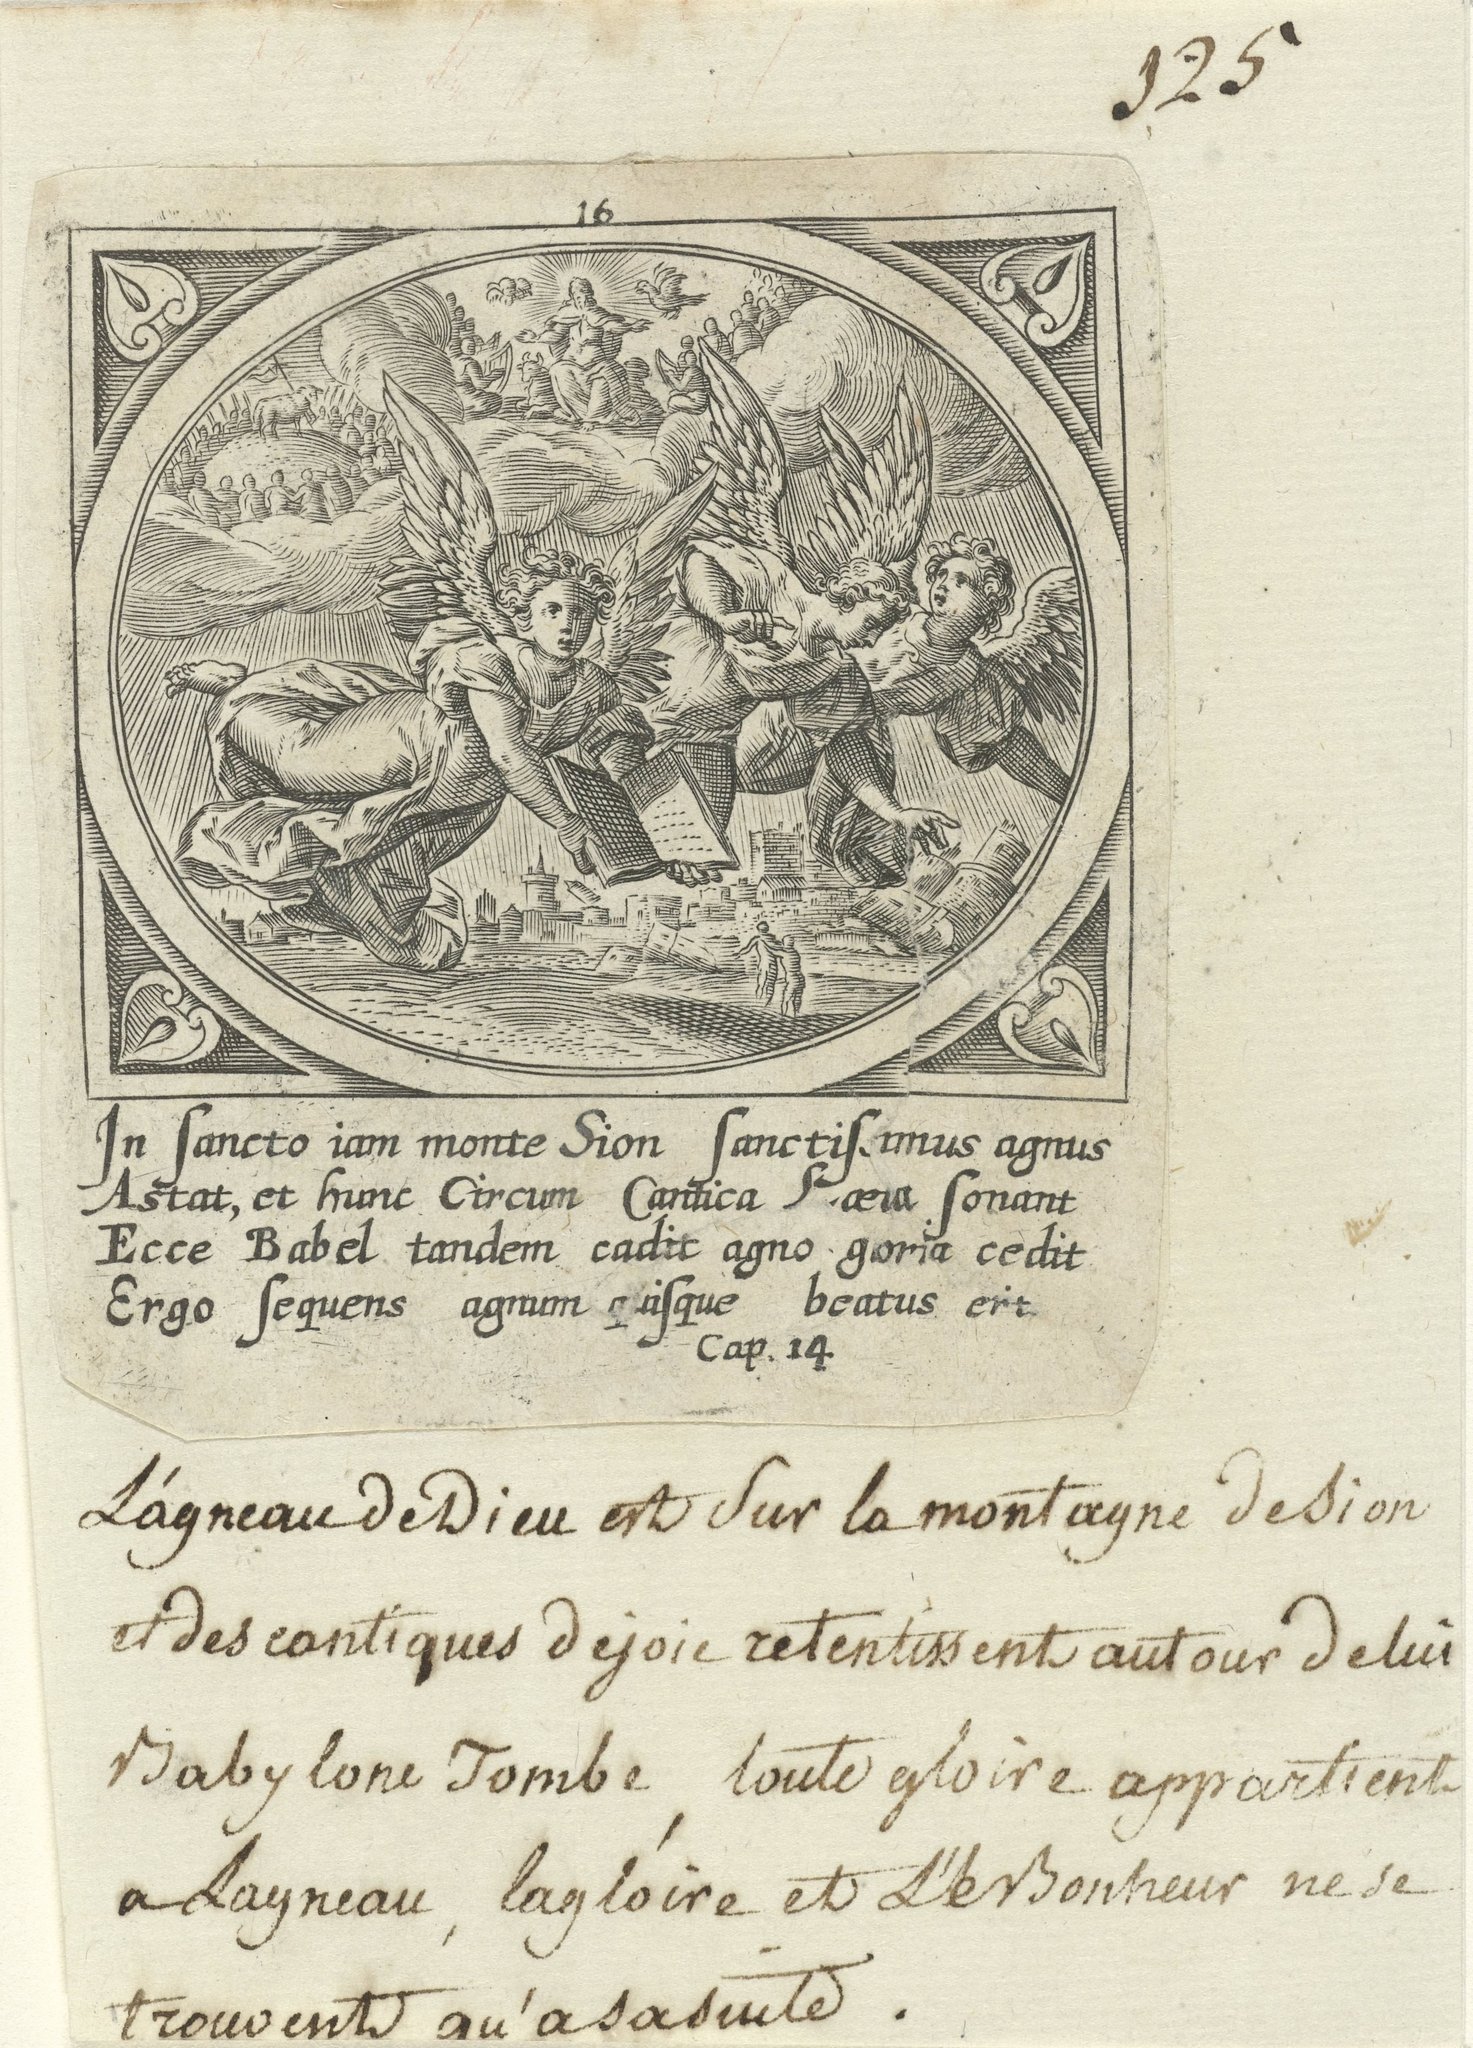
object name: print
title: Aanbidding van het Lam op de berg Sion en drie verkondigende engelen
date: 1585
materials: paper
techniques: engraving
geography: antwerp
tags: the three angels proclaiming the day of judgement, adoration of the lamb on mount sion by the 144-thousand ~ apocalypse (+ angel(s) floating in the air)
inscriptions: inscription: ‘L'agneau e Dieu [...] au asasuite.’, collector's mark: Lugt 2228, inscription: ‘125’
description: Het Lam op de berg Sion omringd door mensen. God de Vader op zijn troon, omringd door de vier wezens en de oudsten. In het midden drie engelen: de eerste houdt het eeuwige evangelie vast en kondigt de dag des oordeels aan, de tweede de val van Babylon. De derde engel waarschuwt tegen de aanbidding van het beest en het beeld, want als straf zal men de wijn van Gods woede moeten drinken. In de marge een vierregelig onderschrift in het Latijn. Zestiende prent uit een serie van vierentwintig met de openbaring van Johannes op Patmos.